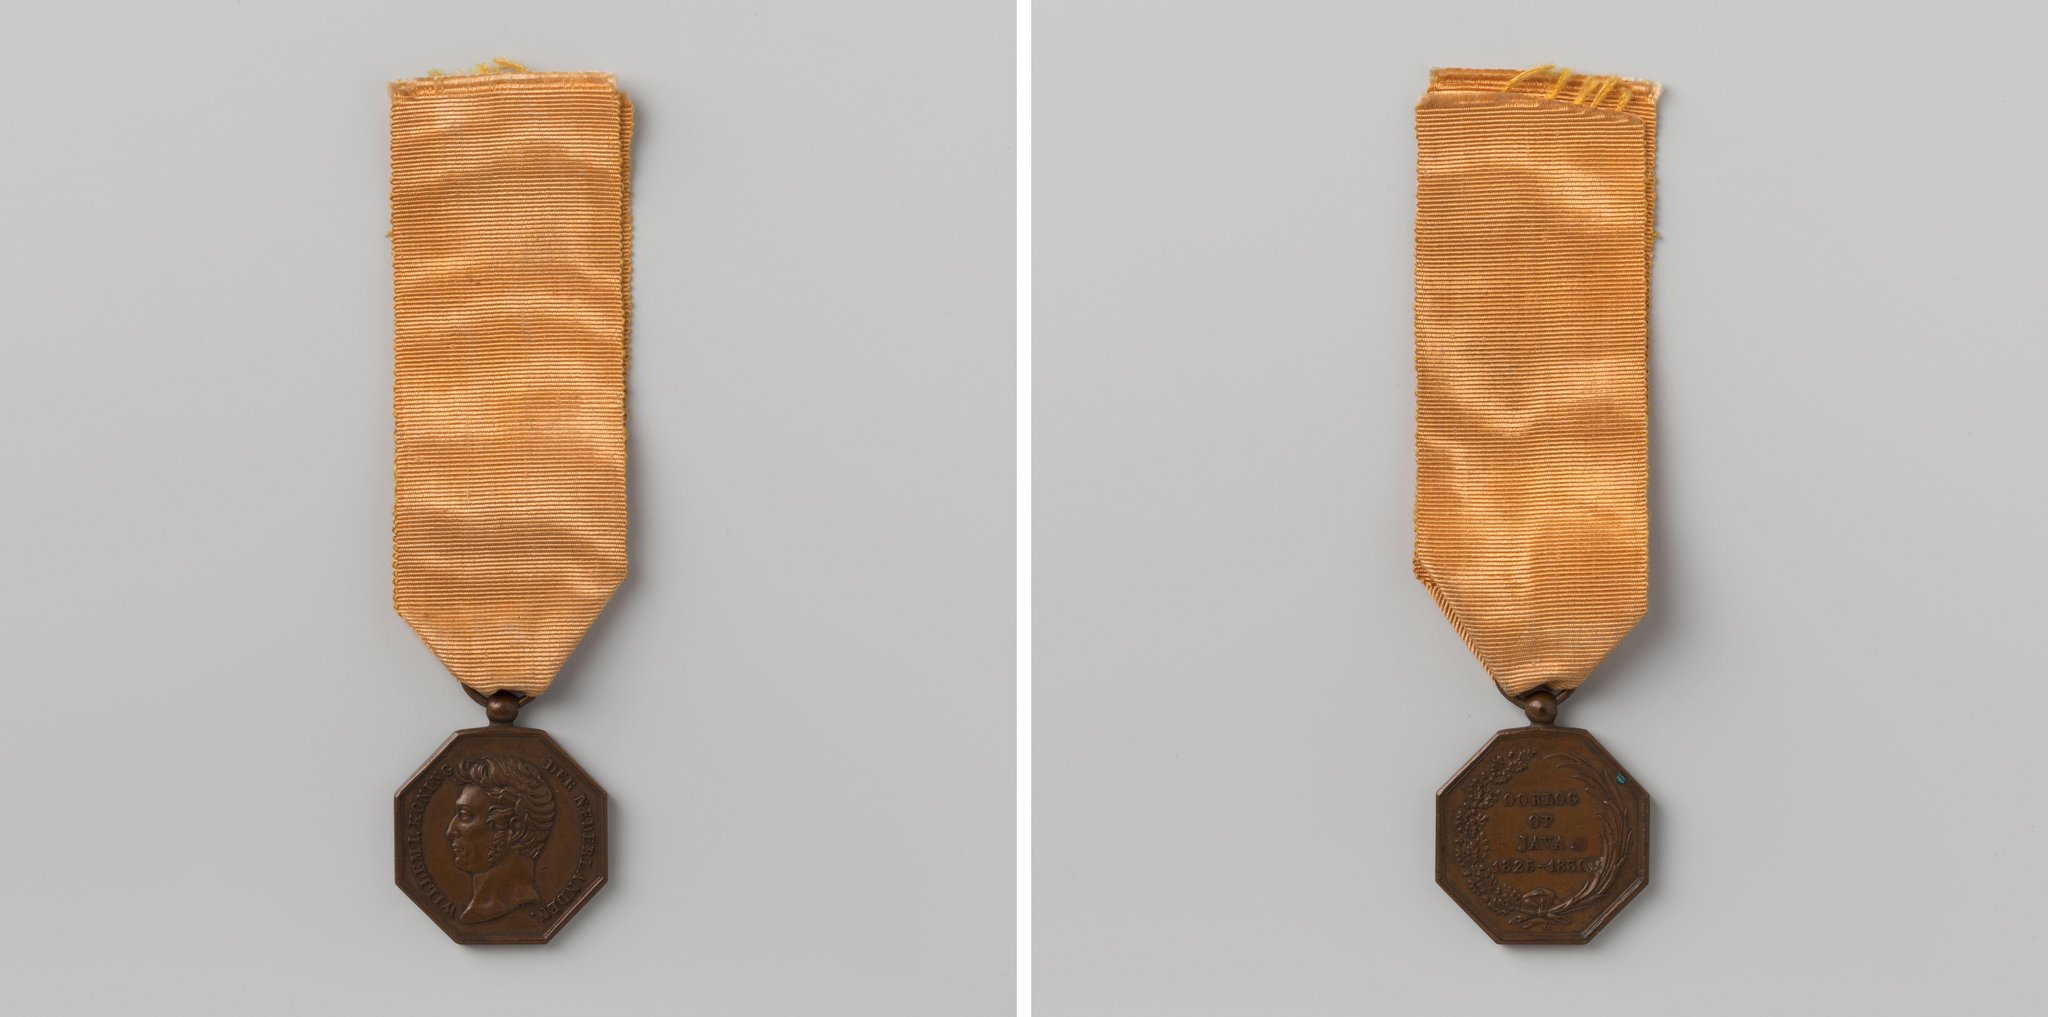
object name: insignia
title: Erepennimng voor de Oorlog op Java 1825-1830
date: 1830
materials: bronze, textile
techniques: striking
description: Achthoekige koperen penning met bal en draagring aan een oranje lint, op de voorzijde het portret van Koning Willem I naar links met omschrift, op de keerzijde vier regels tekst tussen samengestrikte eiken- en palmtak.